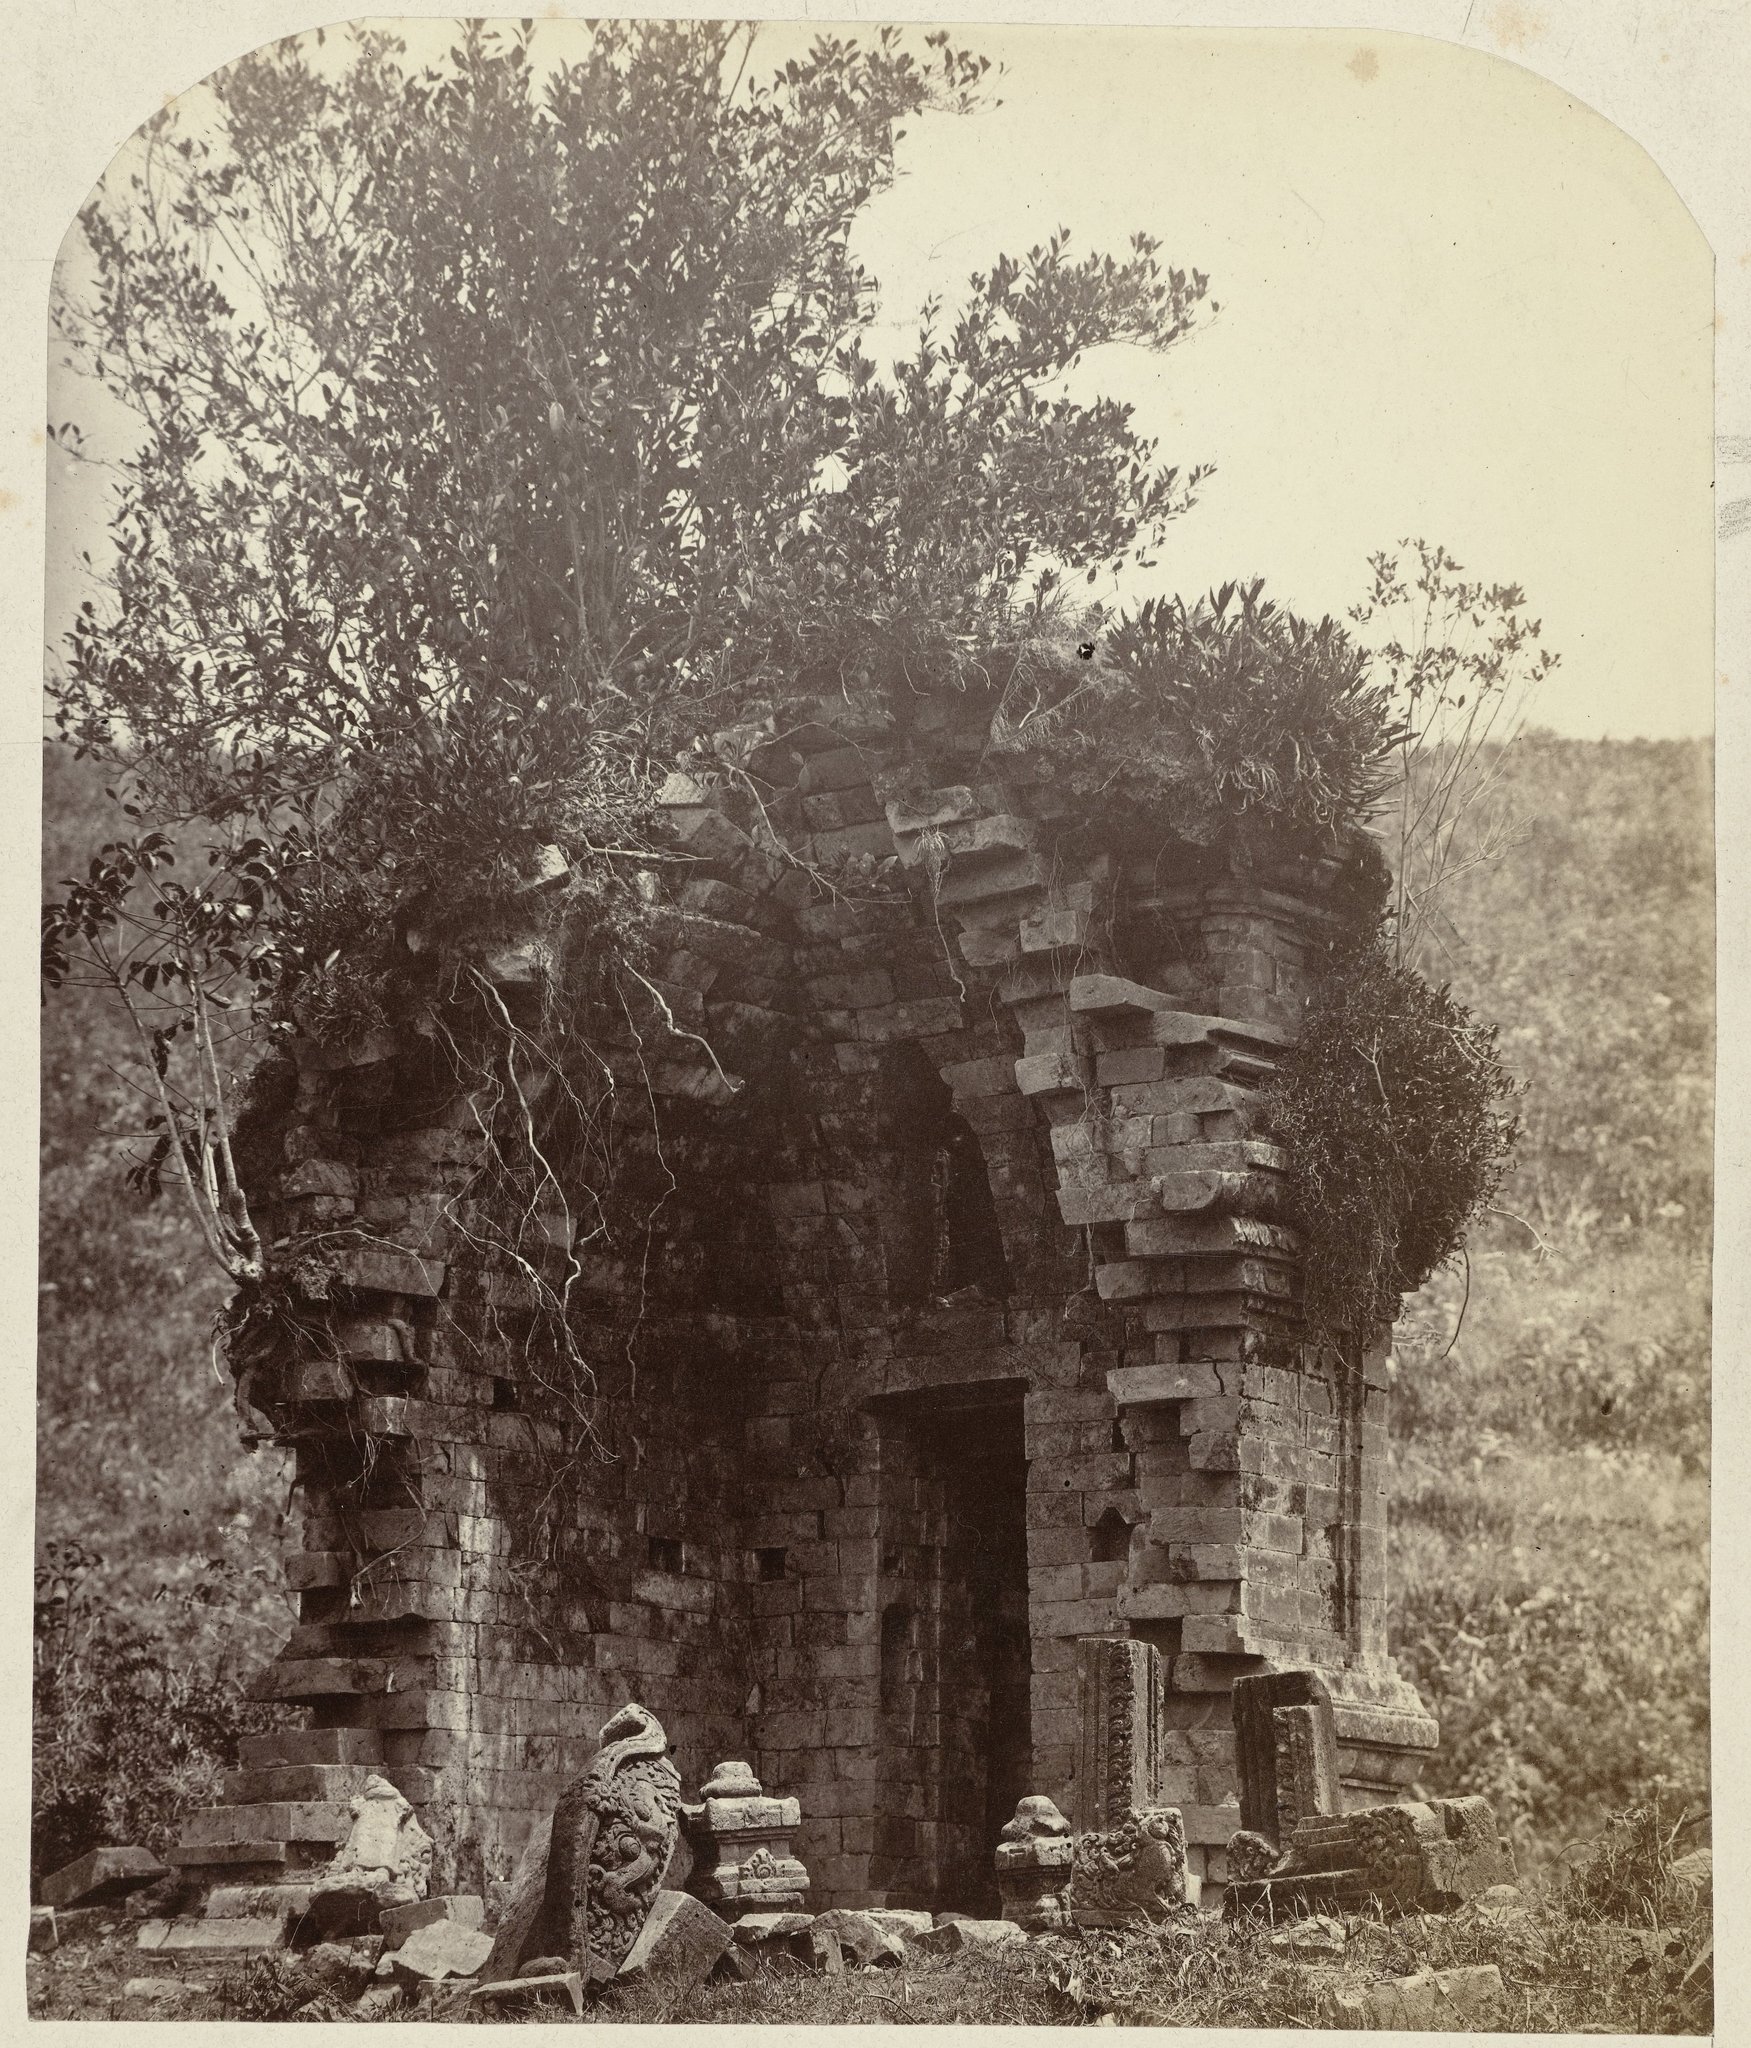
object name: photograph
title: Candi Parakesit, general view of the ruined temple and the scattered sculputal and architectural reamins; the temple dissapeared in 1873. Dieng Plateau, Wonosbo district, Central Java province 8th- 9th century.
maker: isidore kinsbergen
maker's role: fotograaf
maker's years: 1821-1905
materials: cardboard, paper, photographic support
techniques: albumen print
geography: java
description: Een tempel ruine in Parakesit gebouwd in de achtste of negende eeuw, in 1873 is de tempel definitief verdwenen.